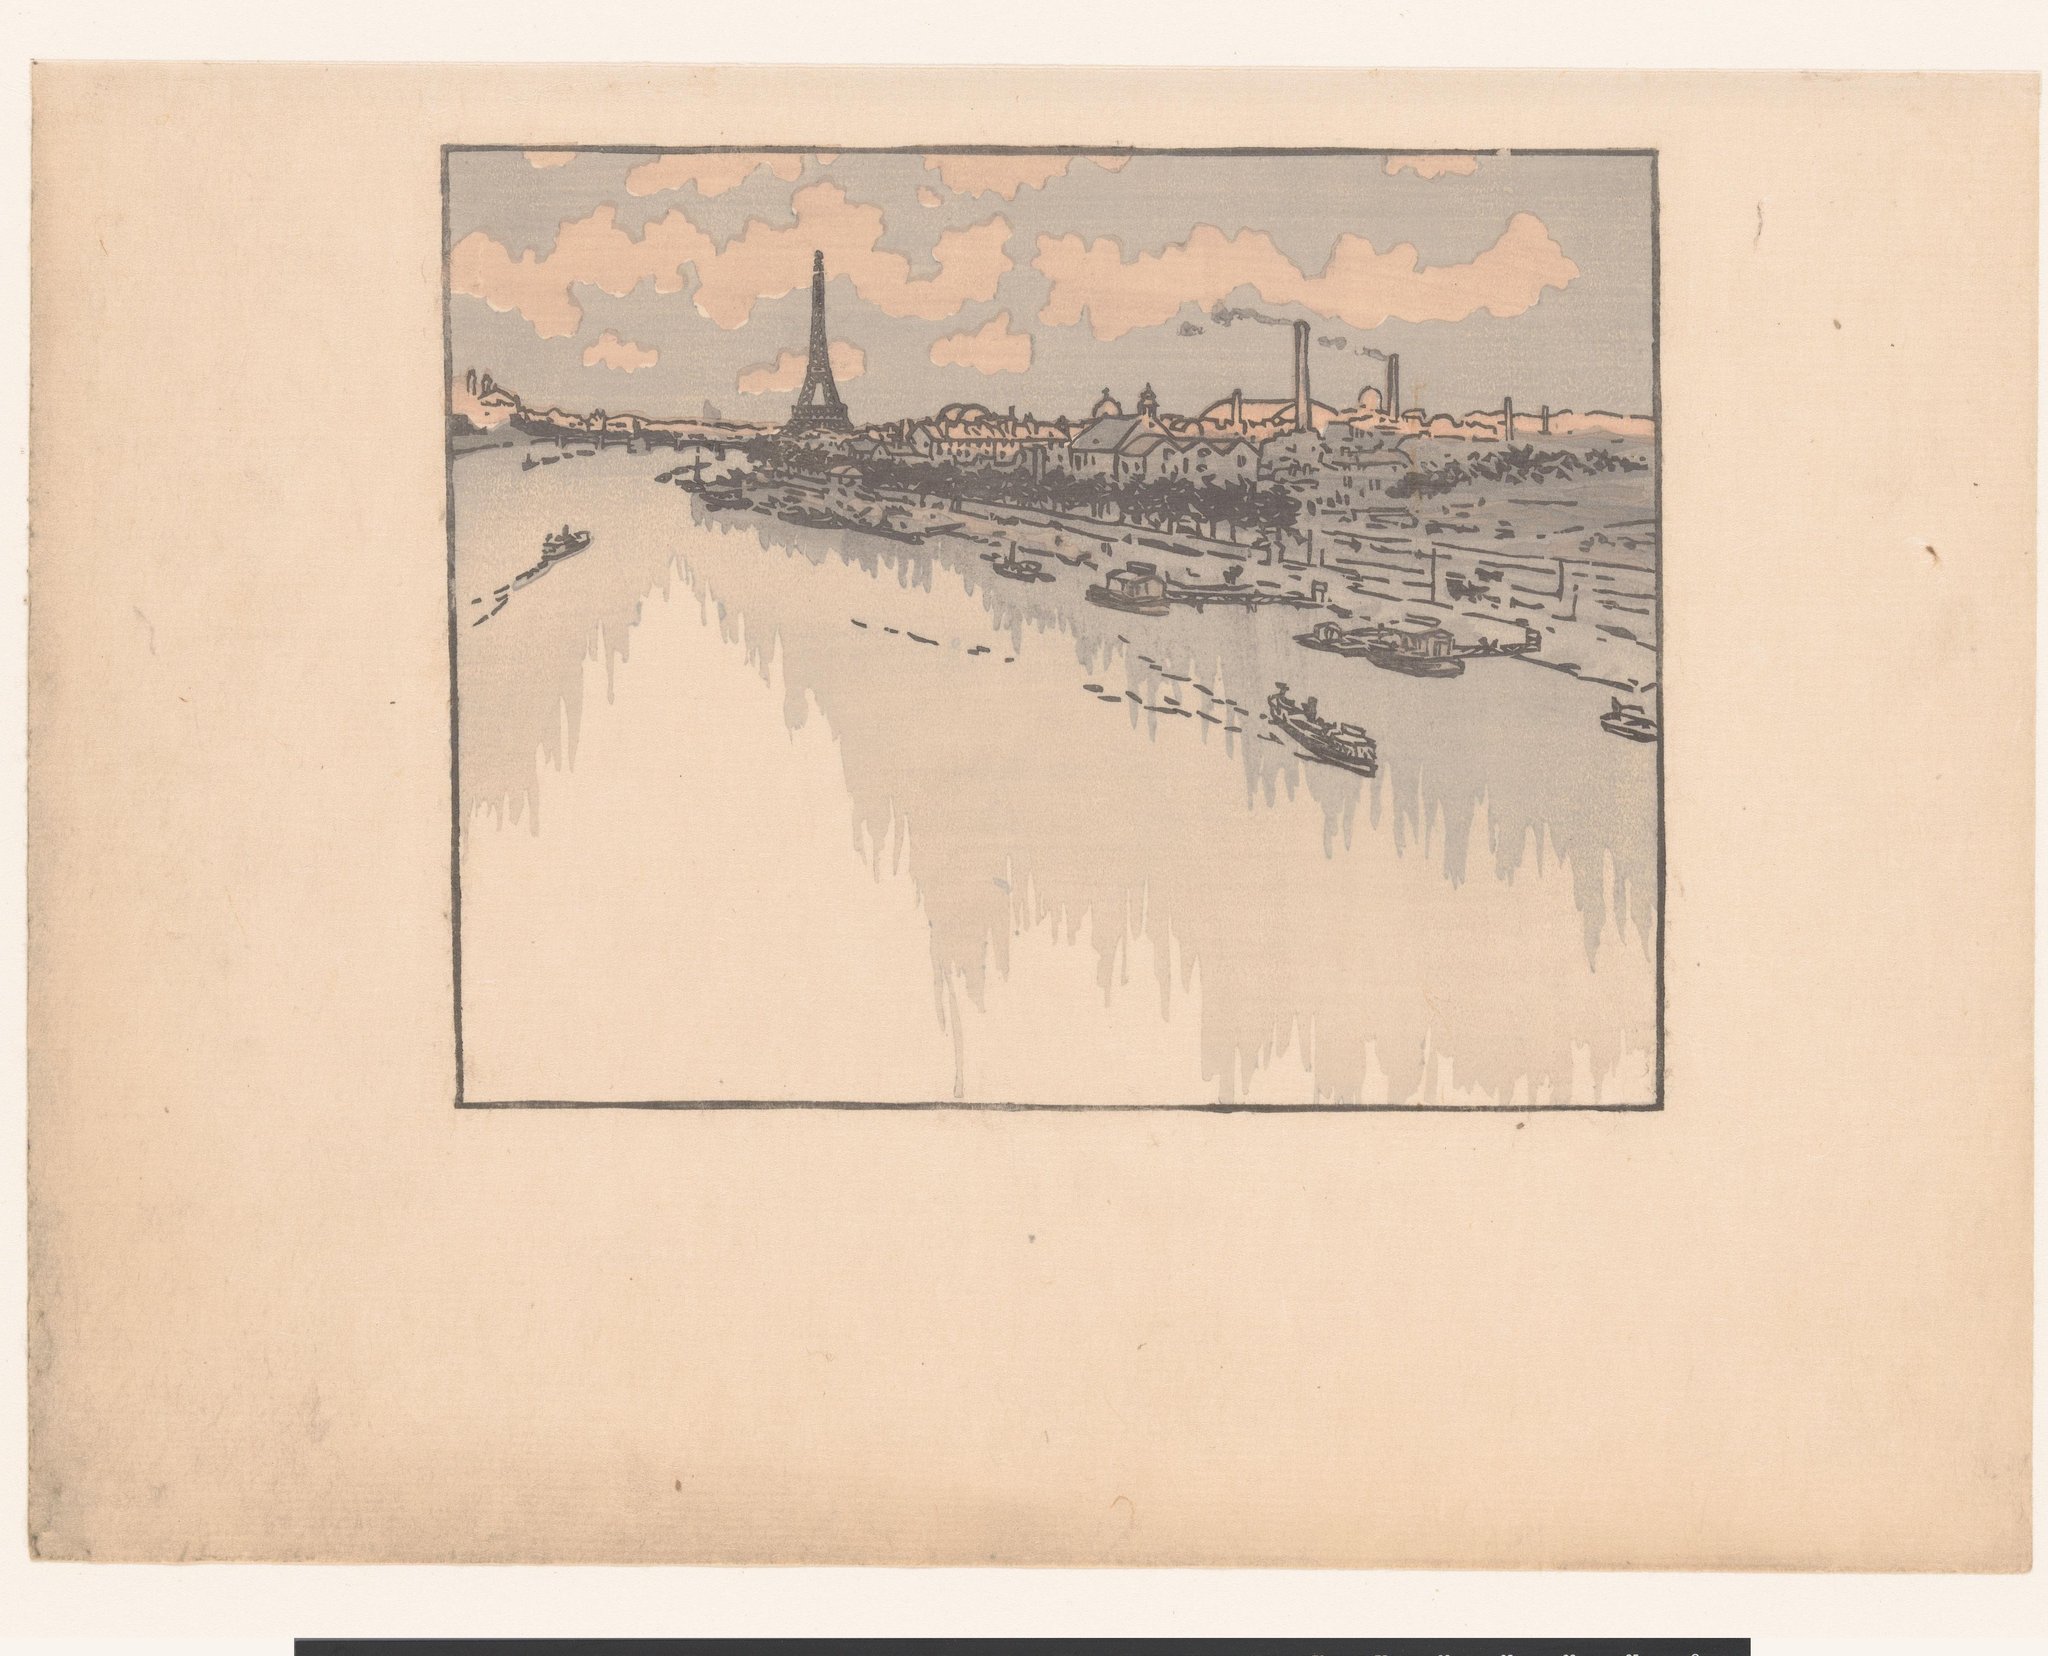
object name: print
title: Eiffeltoren gezien van het viaduct van Auteuil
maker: henri rivière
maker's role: draughtsman, print maker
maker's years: 1864-1951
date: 1891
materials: paper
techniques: woodcut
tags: city-view, and landscape with man-made constructions, eiffel tower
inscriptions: collector's mark: Lugt 2228